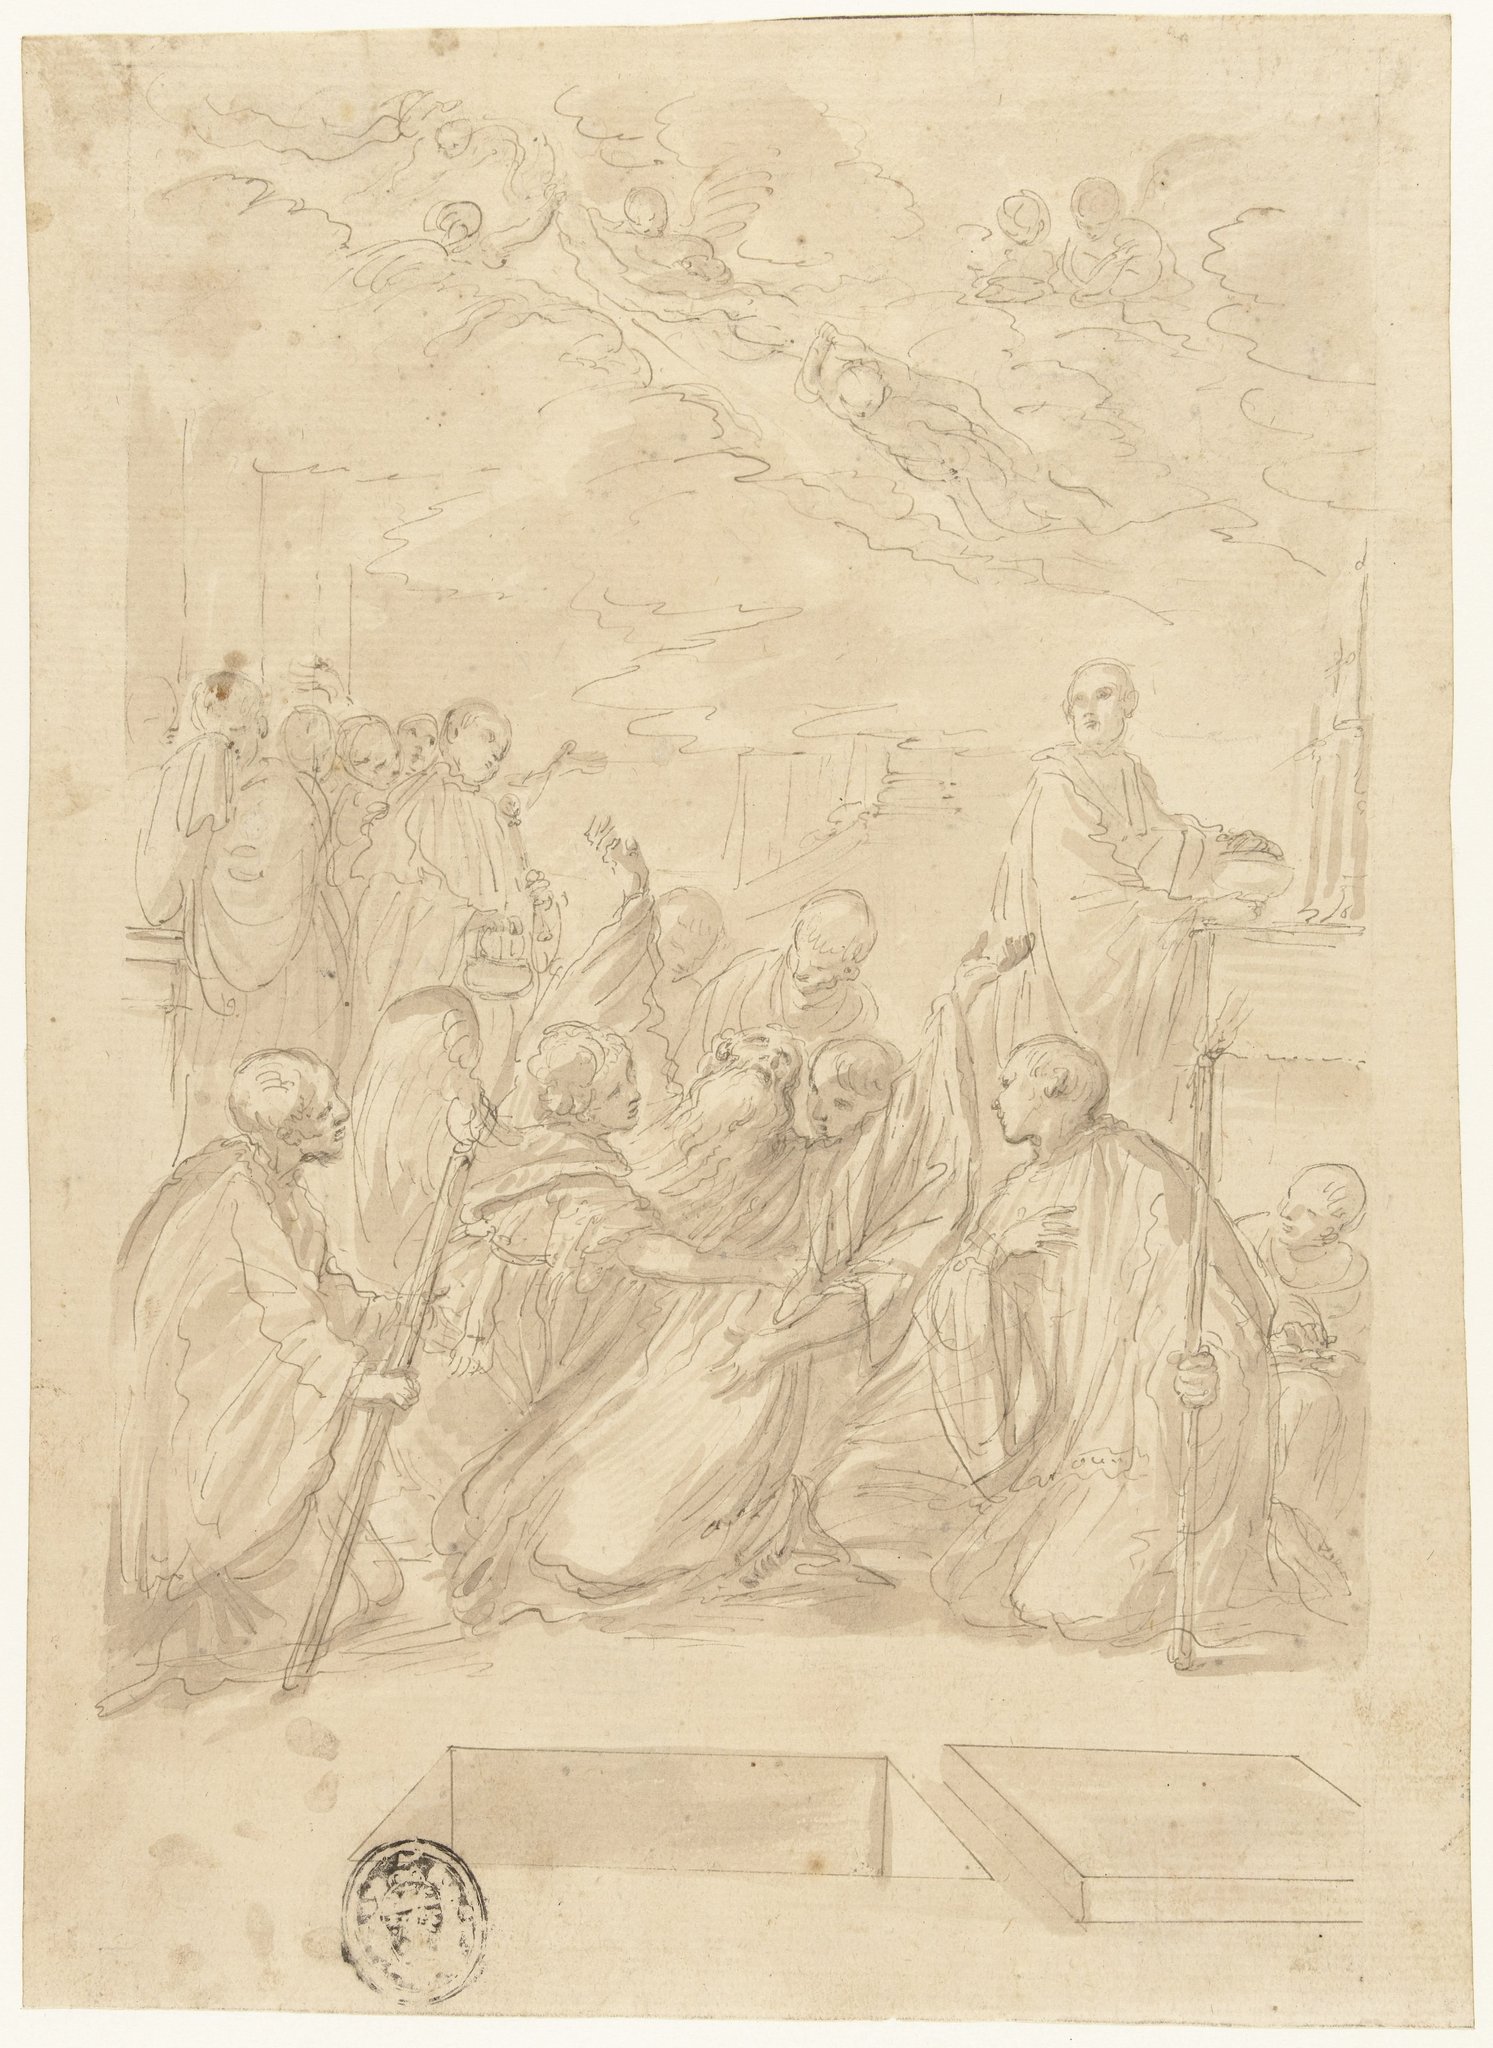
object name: drawing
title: De dood van de Heilige Benedictus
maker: domenico maria canuti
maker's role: draughtsman, print maker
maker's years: 1620-1684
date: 1662-1671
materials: ink, paper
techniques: brush, pen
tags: benedict of nurcia, abbot of monte cassino and founder of the benedictine order; possible attributes: aspergillum, book, cup (sometimes broken), raven with loaf, sieve (or tray)